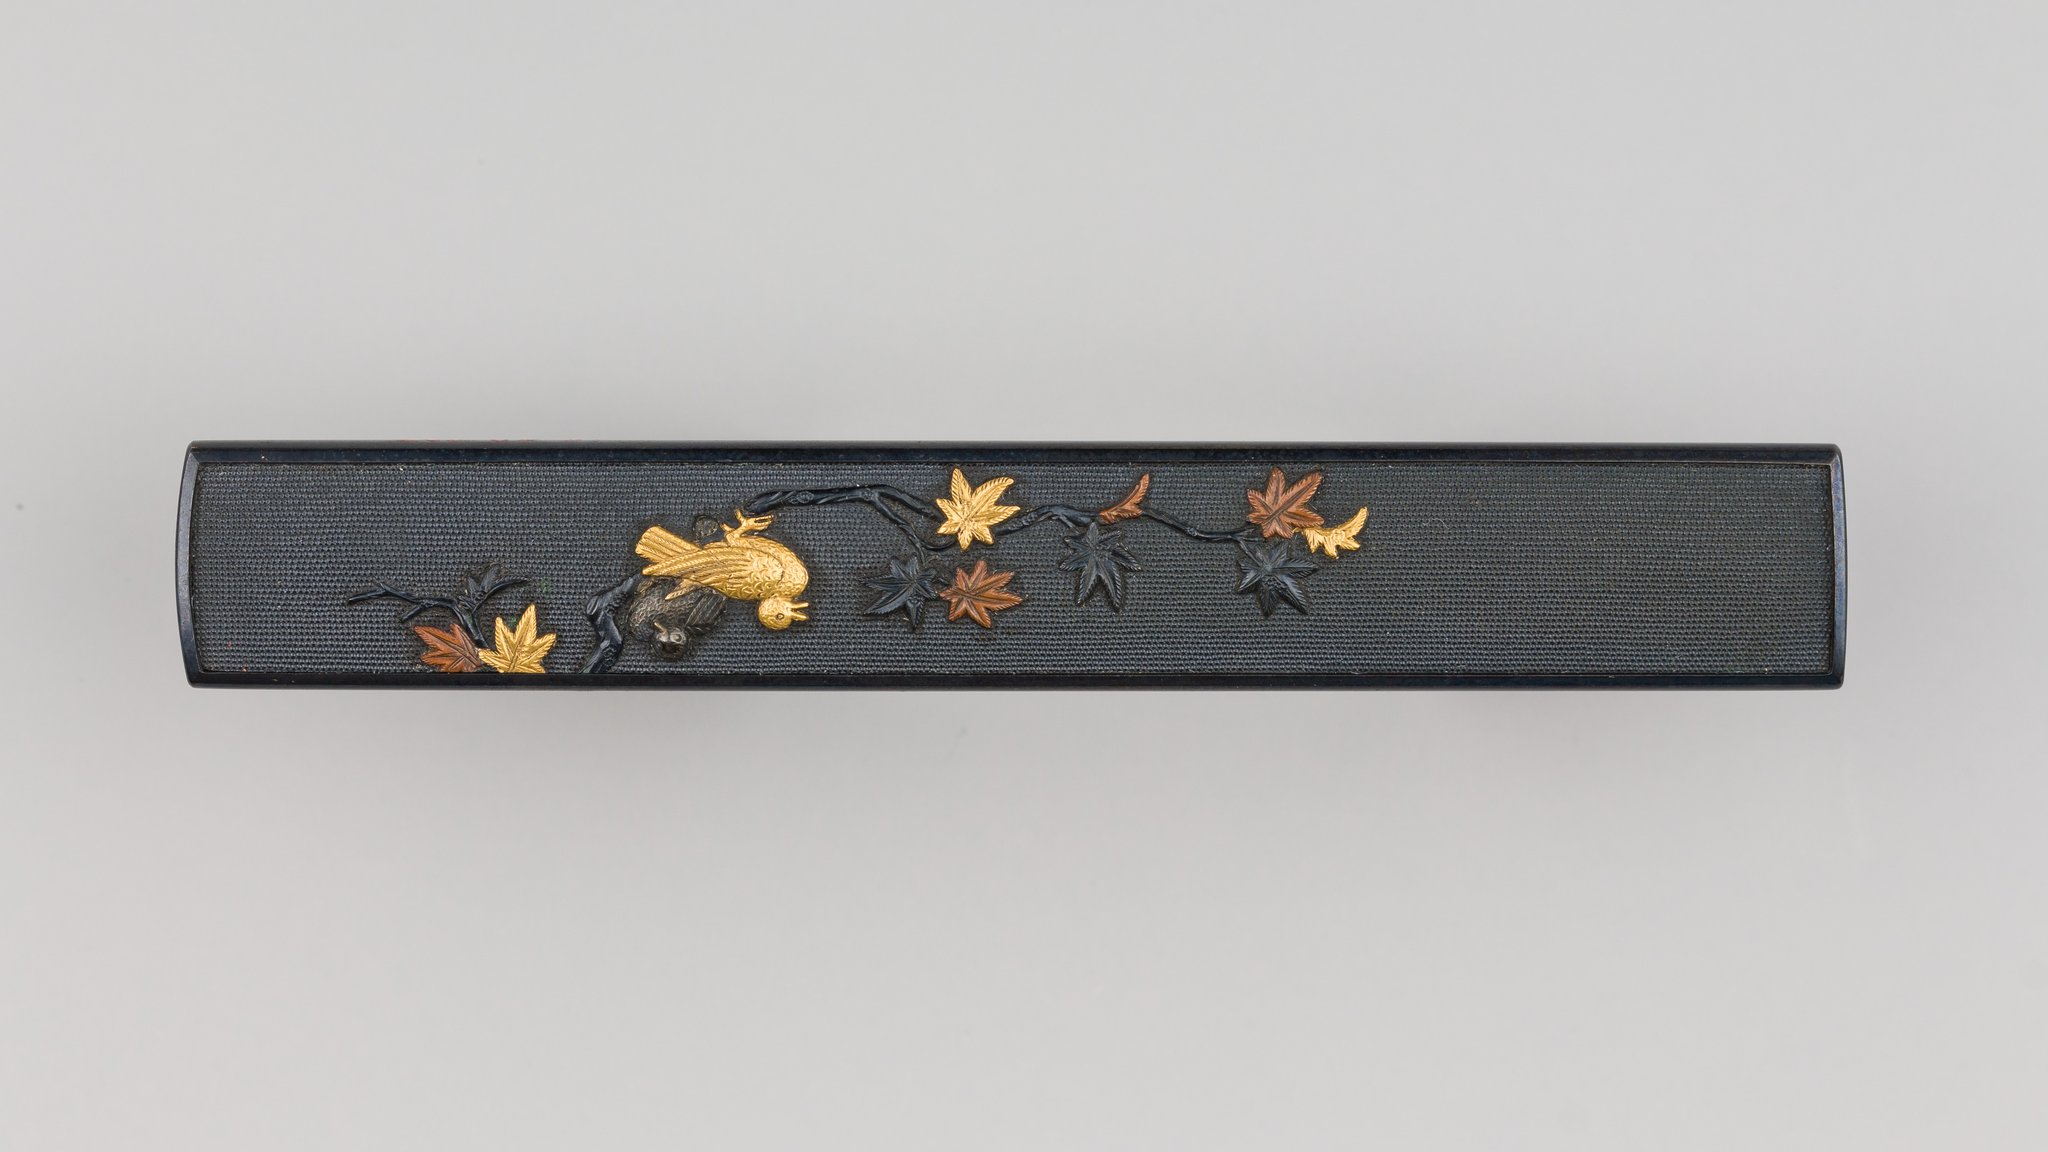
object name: knife handle kozuka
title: Knife Handle (Kozuka)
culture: japanese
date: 1801-1900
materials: copper, gold alloy, silver alloy, gold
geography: japan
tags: birds,flowers,leaves